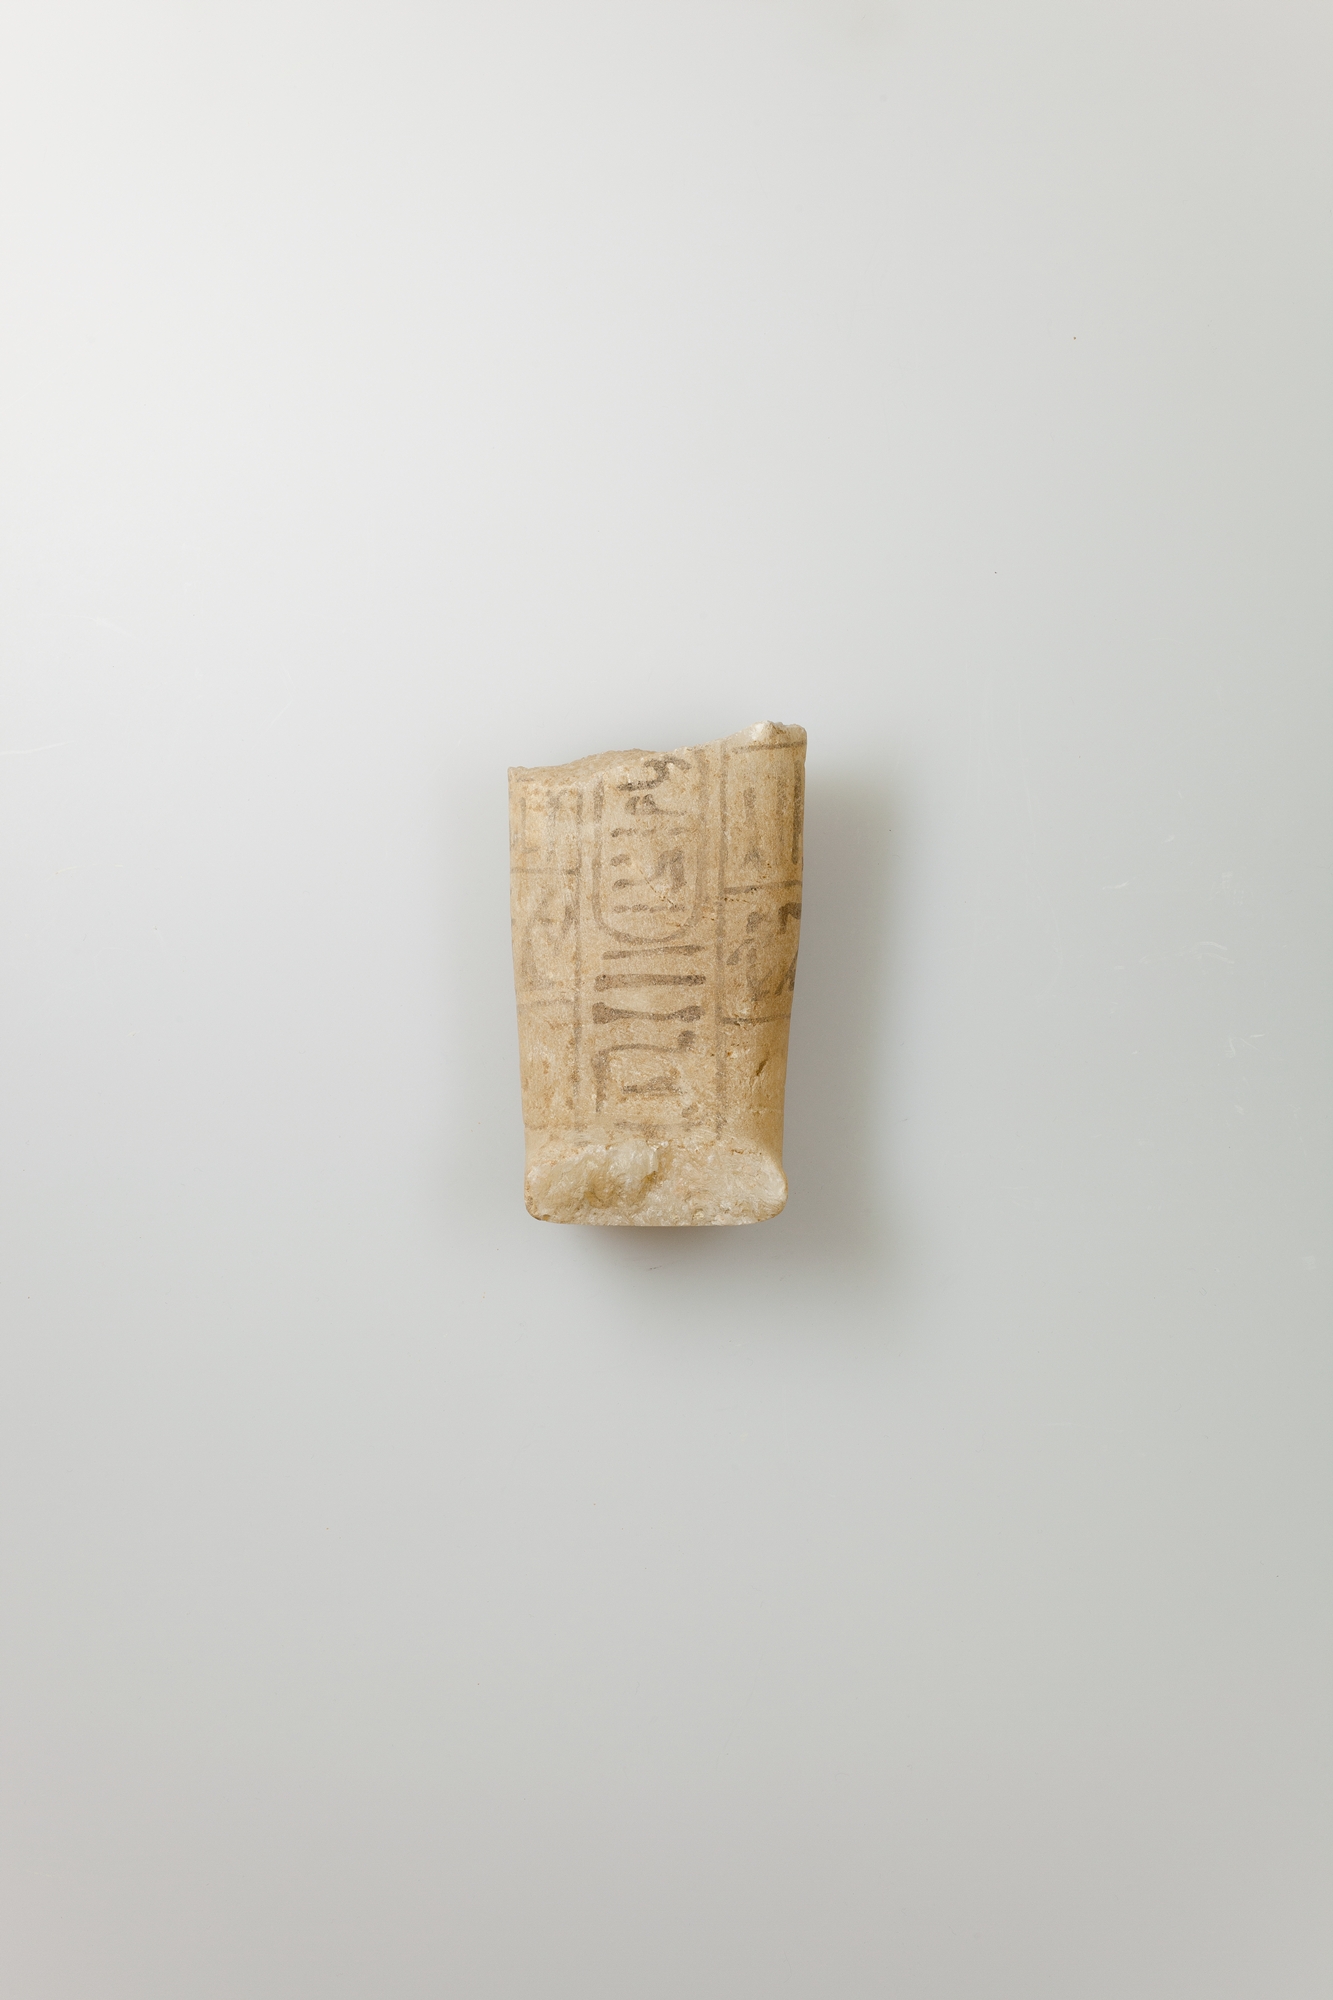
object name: shabti, siptah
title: Shabti of Siptah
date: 1194-1188 BCE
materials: stone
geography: egypt